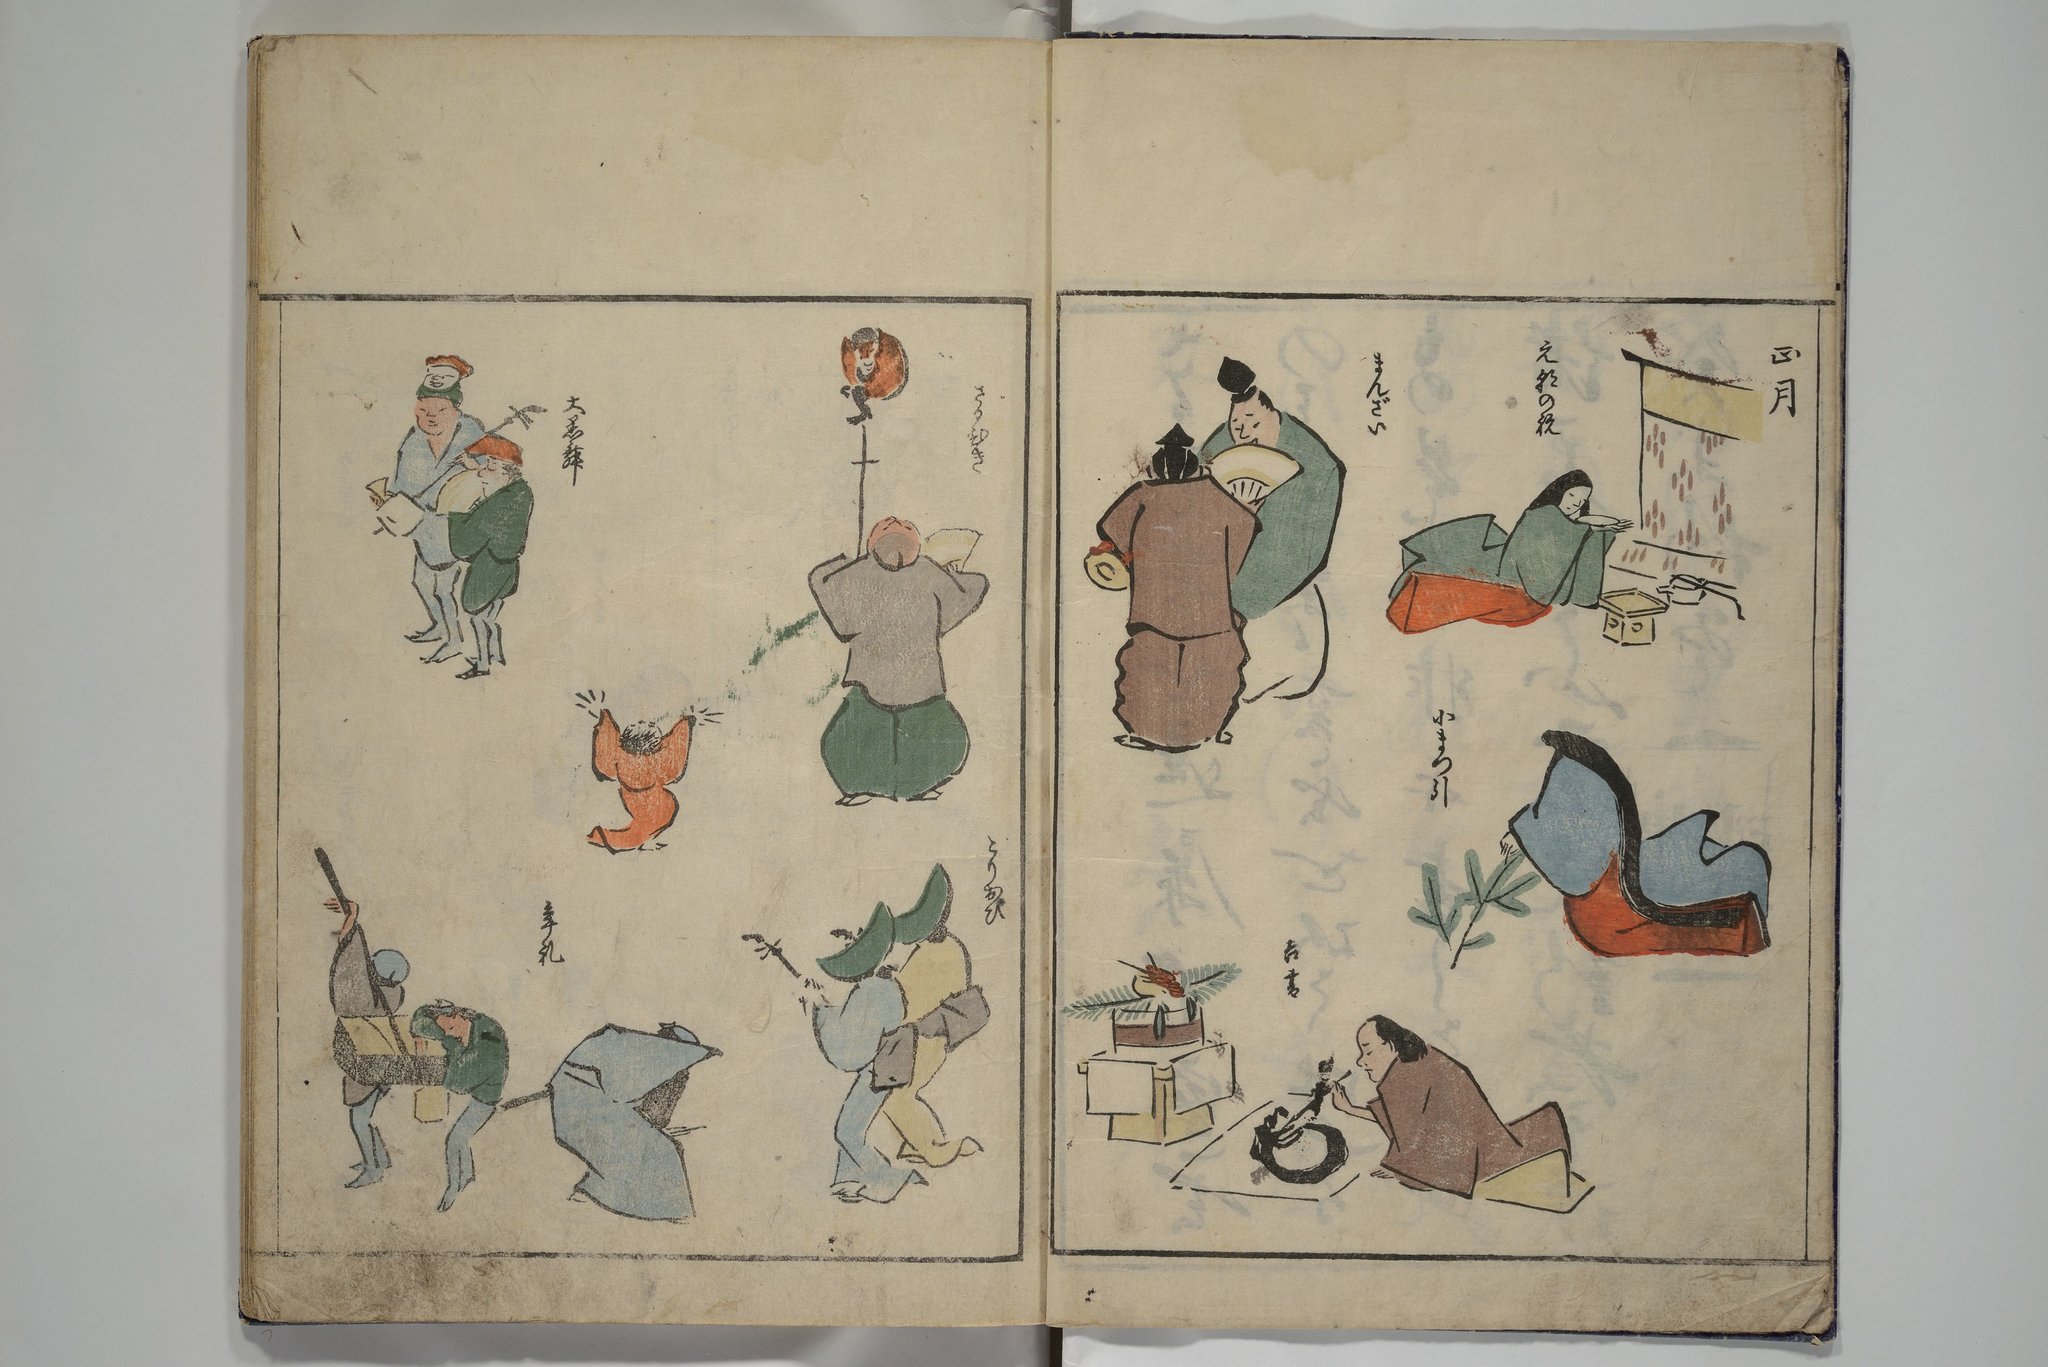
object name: illustrated book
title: Garden of Cursive Drawings (Ryakuga-en) 略画苑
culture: japanese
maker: kuwagata keisai 鍬形蕙斎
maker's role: artist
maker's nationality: japanese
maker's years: 1764-1824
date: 1823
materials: ink, paper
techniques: woodblock print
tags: men,women